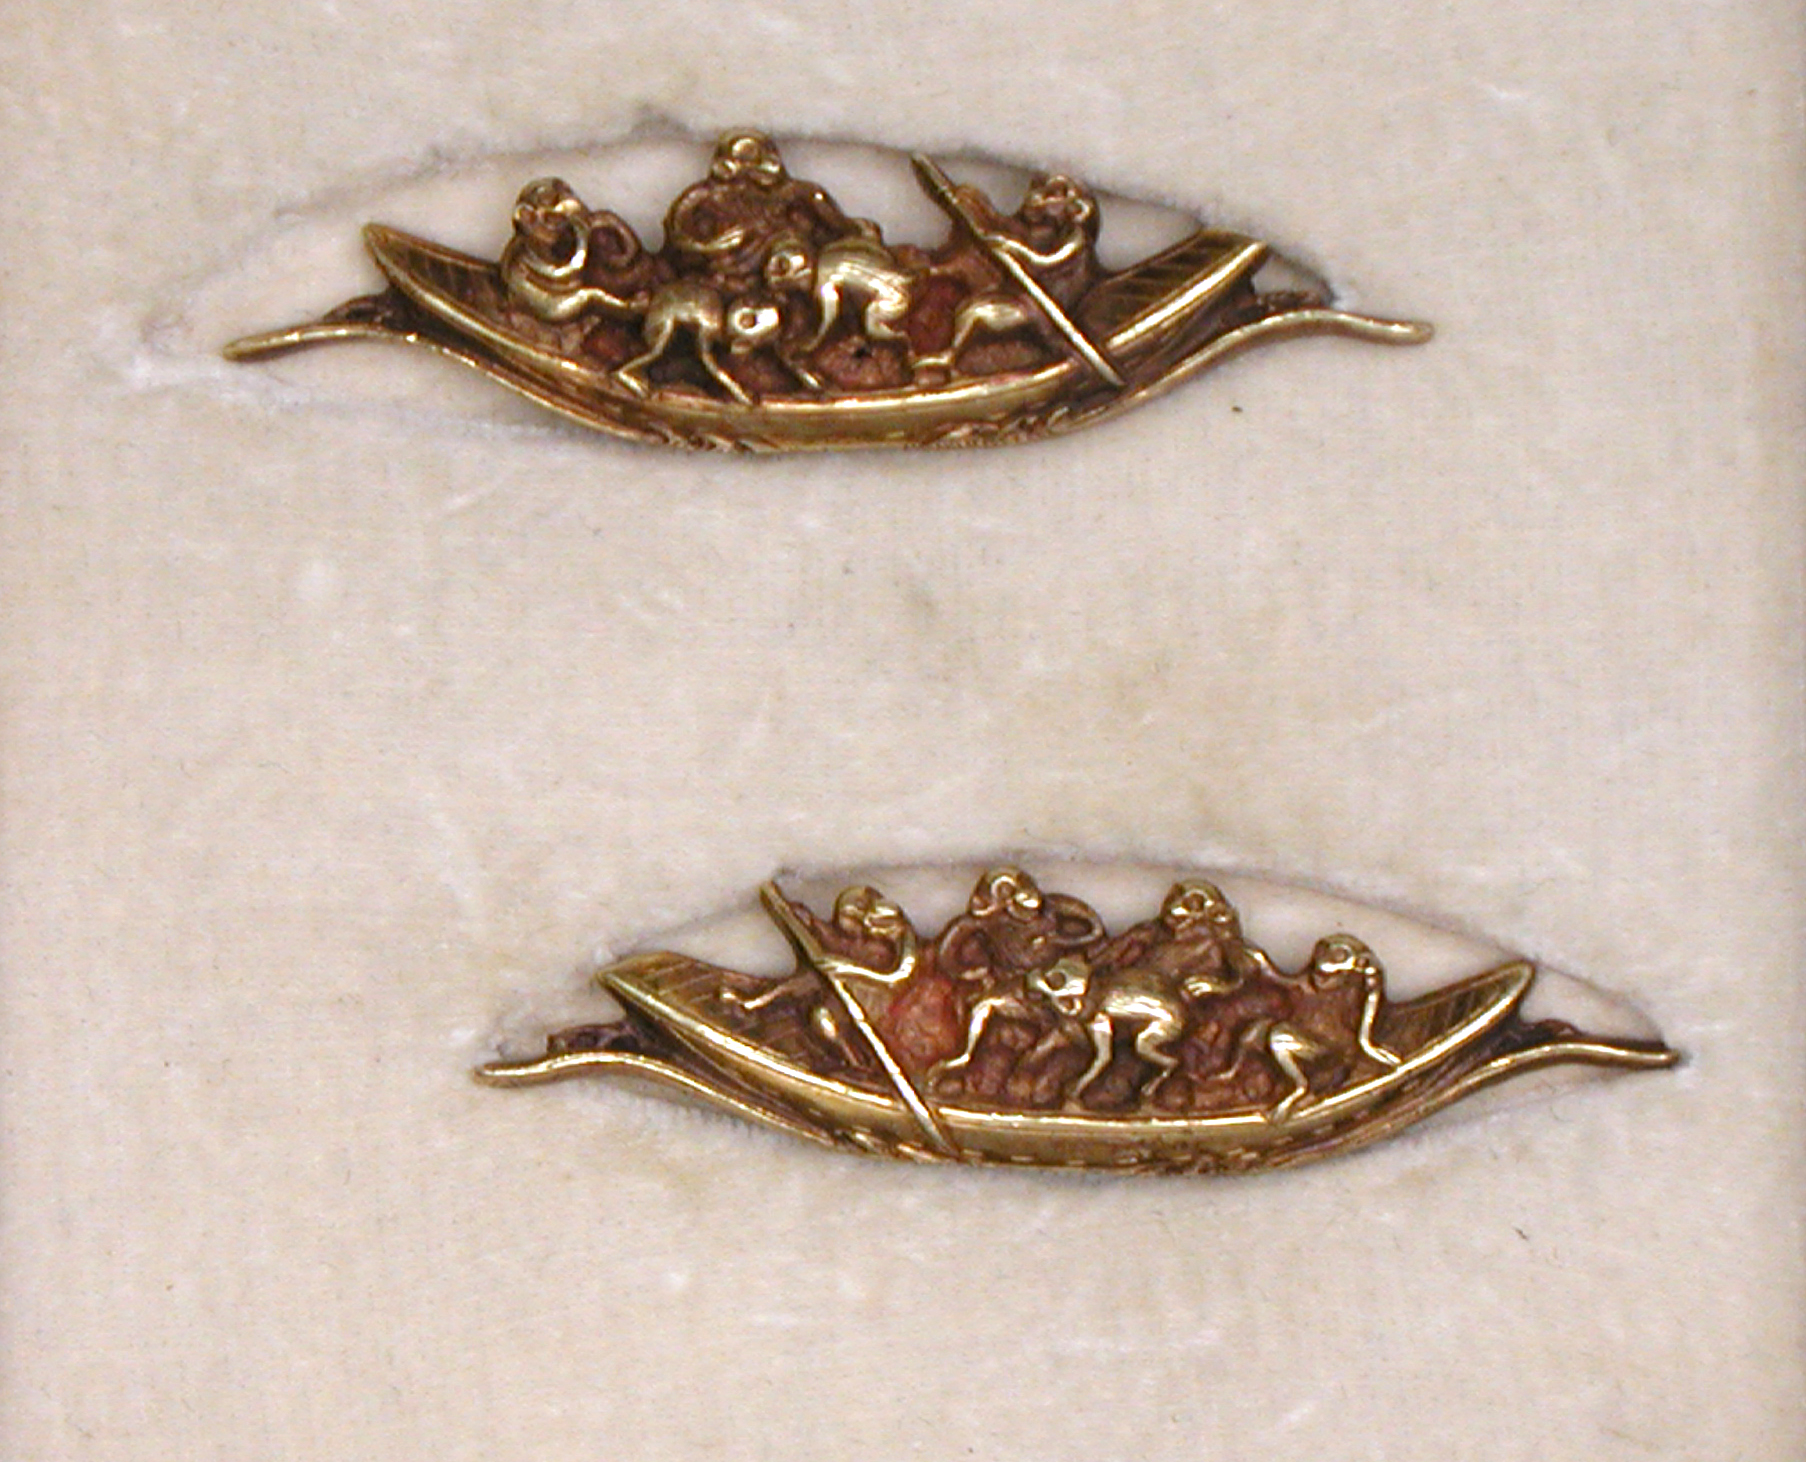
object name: pair of sword grip ornament menuki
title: Pair of Sword-Grip Ornaments (Menuki)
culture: japanese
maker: tsu jumpo (jimpo)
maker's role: maker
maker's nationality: japanese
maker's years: 1721-1762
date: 1750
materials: gold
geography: japan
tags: sailing